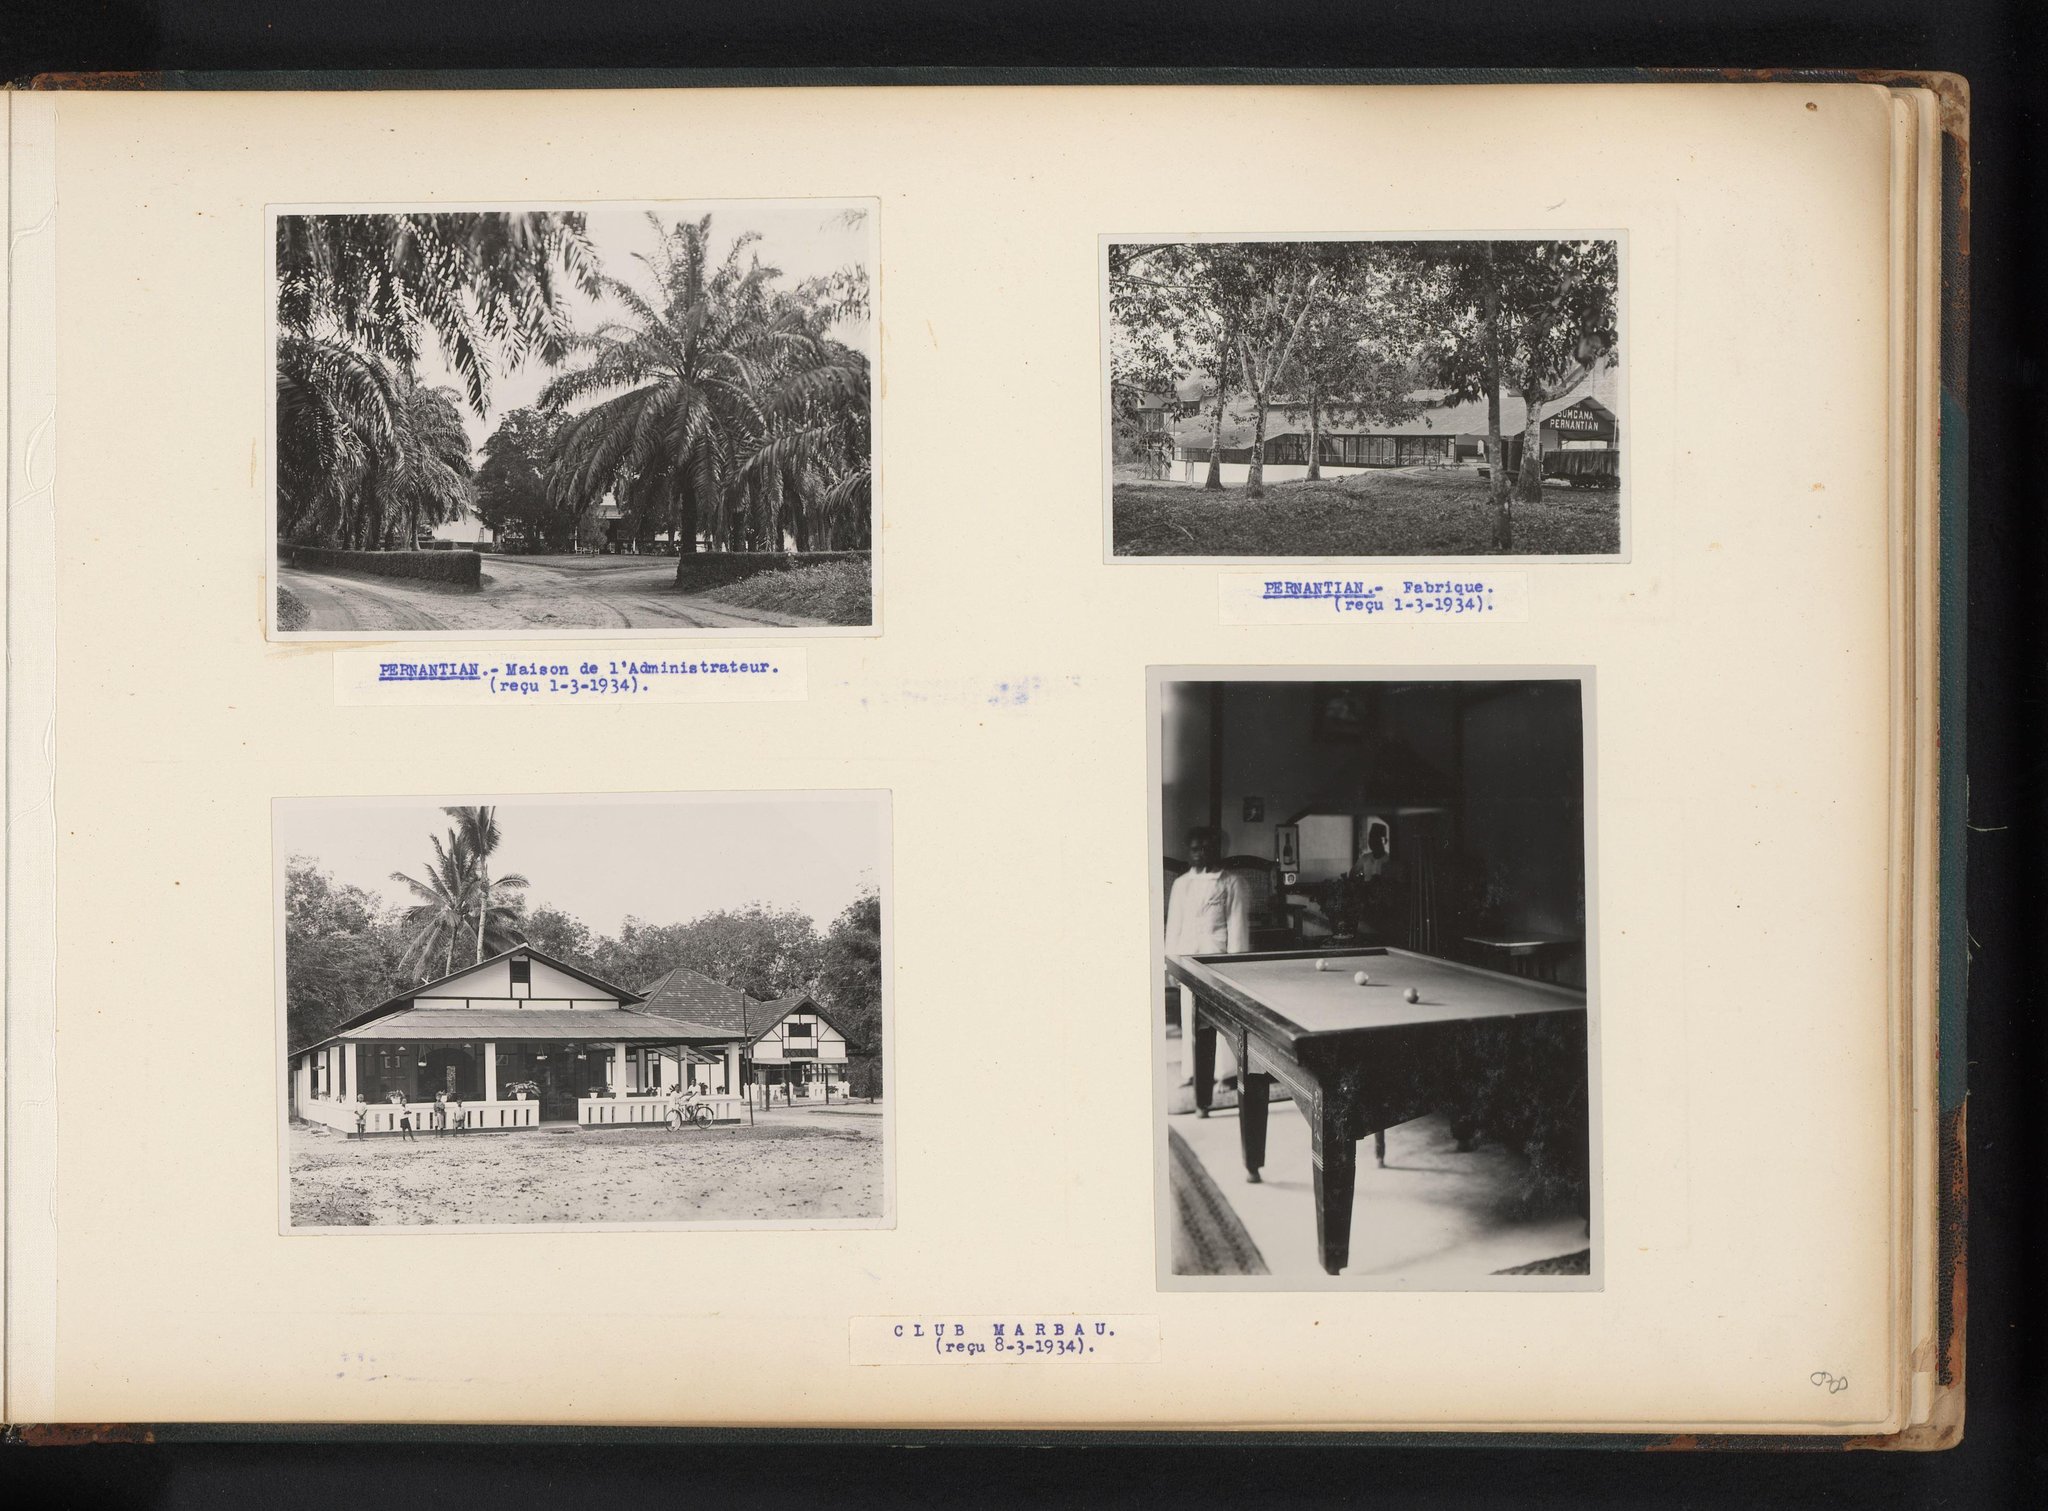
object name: album leaf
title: Bedrijfsgebouwen op Pernantian, 1934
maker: Anonymous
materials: cardboard, photographic support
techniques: gelatin silver print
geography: sumatra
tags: plantation, billiards, club, meeting place, exterior of industrial structures, factories, sumatra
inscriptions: inscription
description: Blad met vier foto's van bedrijfs- en administratiegebouwen en van de club op Pernantian, 1934. Met etiketten met onderschriften onder de foto's. Onderdeel van het fotoalbum over de plantages Brussel en Pernantian van de Sumatra Caoutchouc Maatschappij op de Oostkust van Sumatra in de jaren 1910-1935.